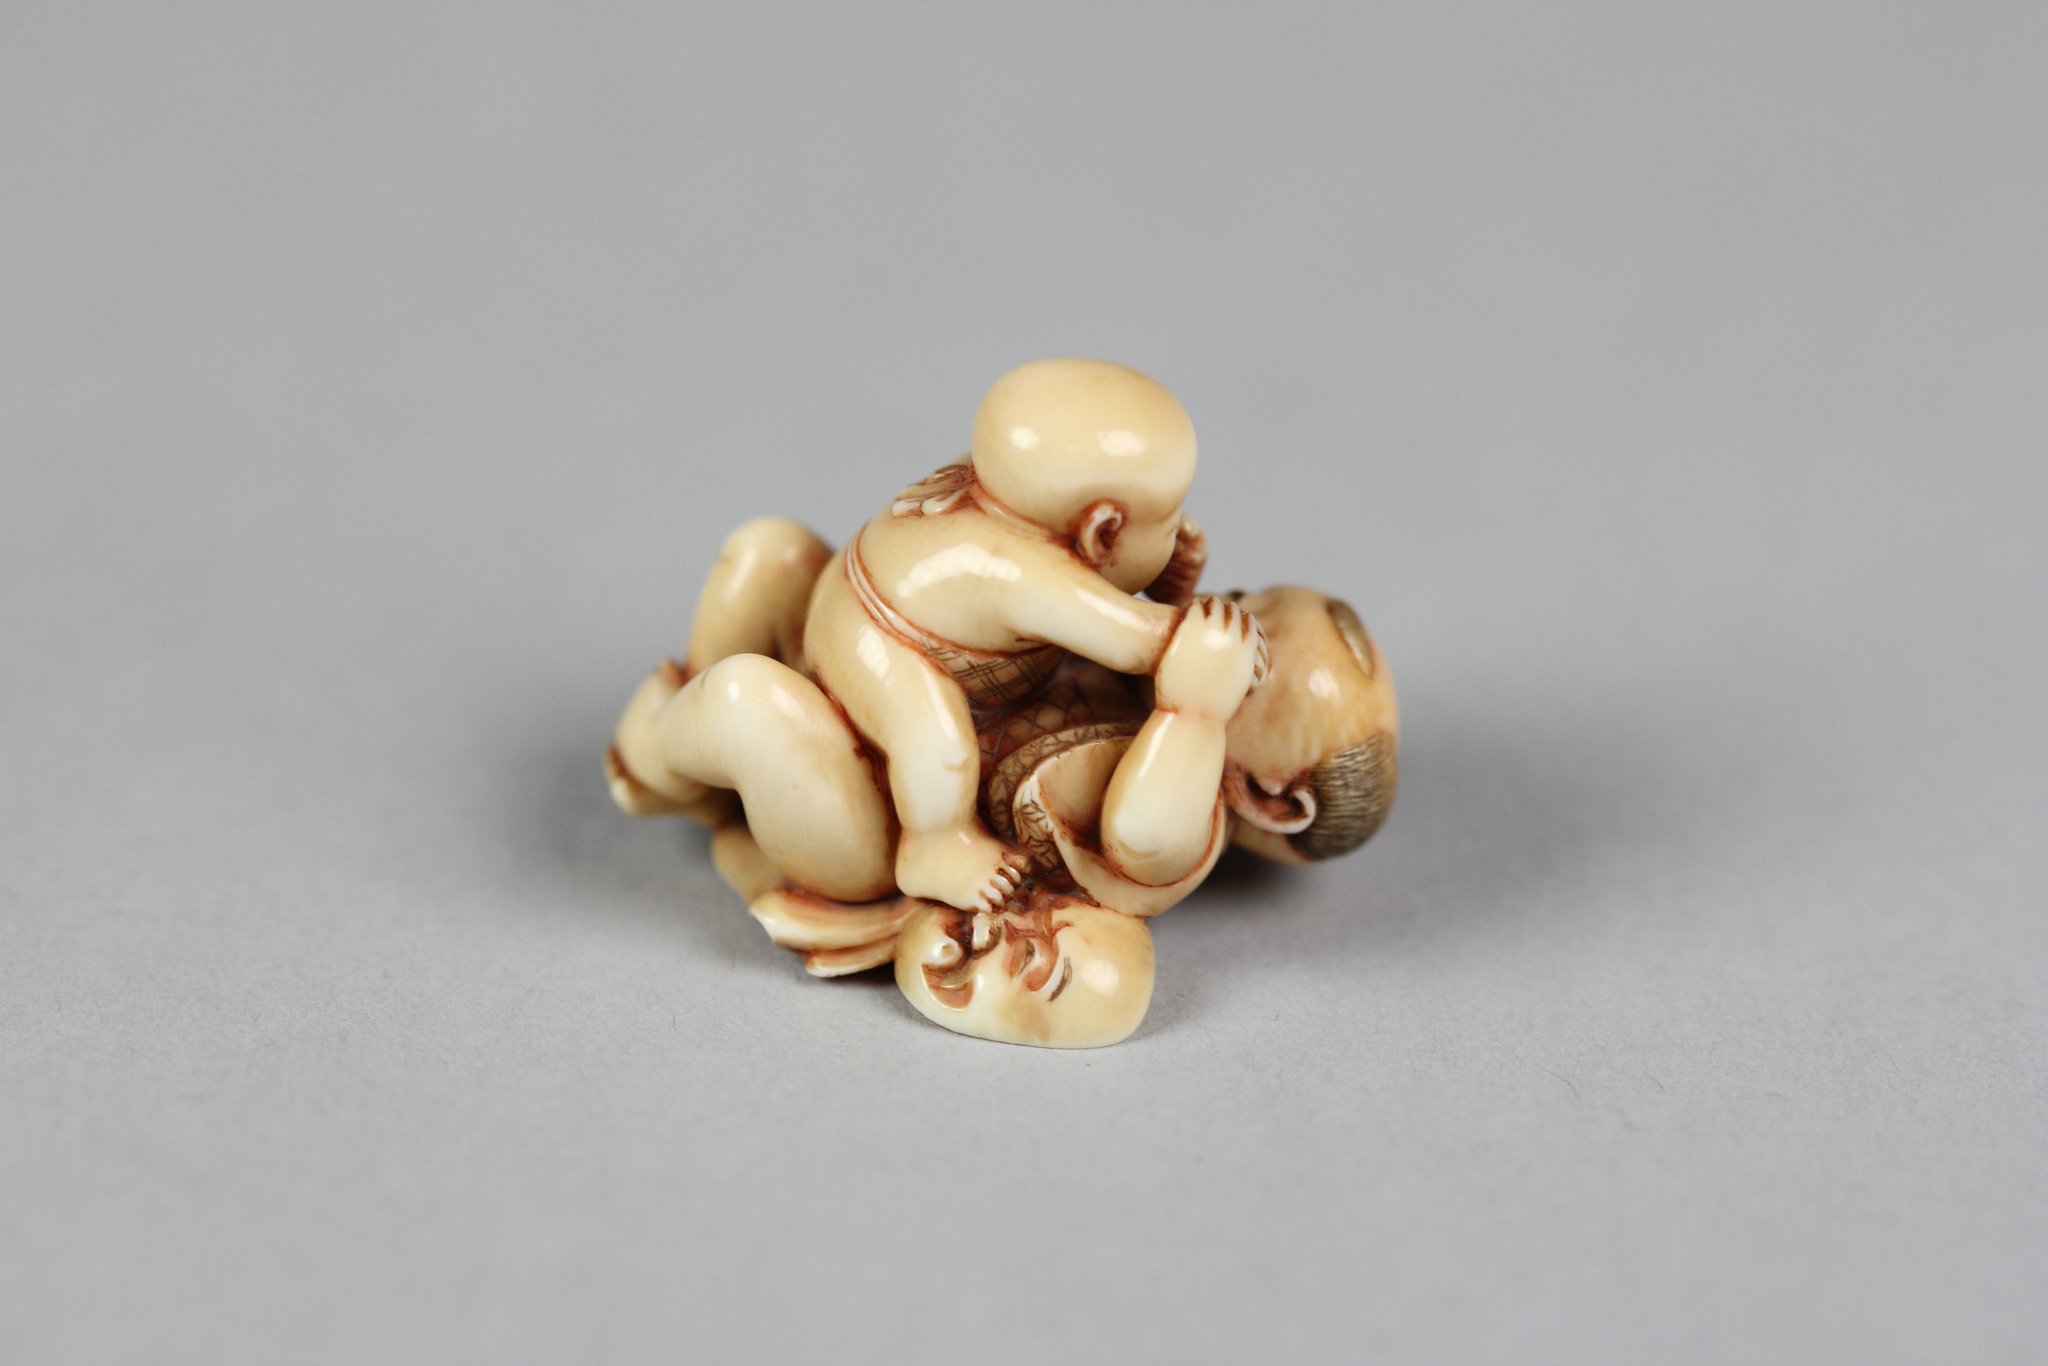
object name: netsuke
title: Netsuke of Children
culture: japanese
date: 1801-1900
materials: ivory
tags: children